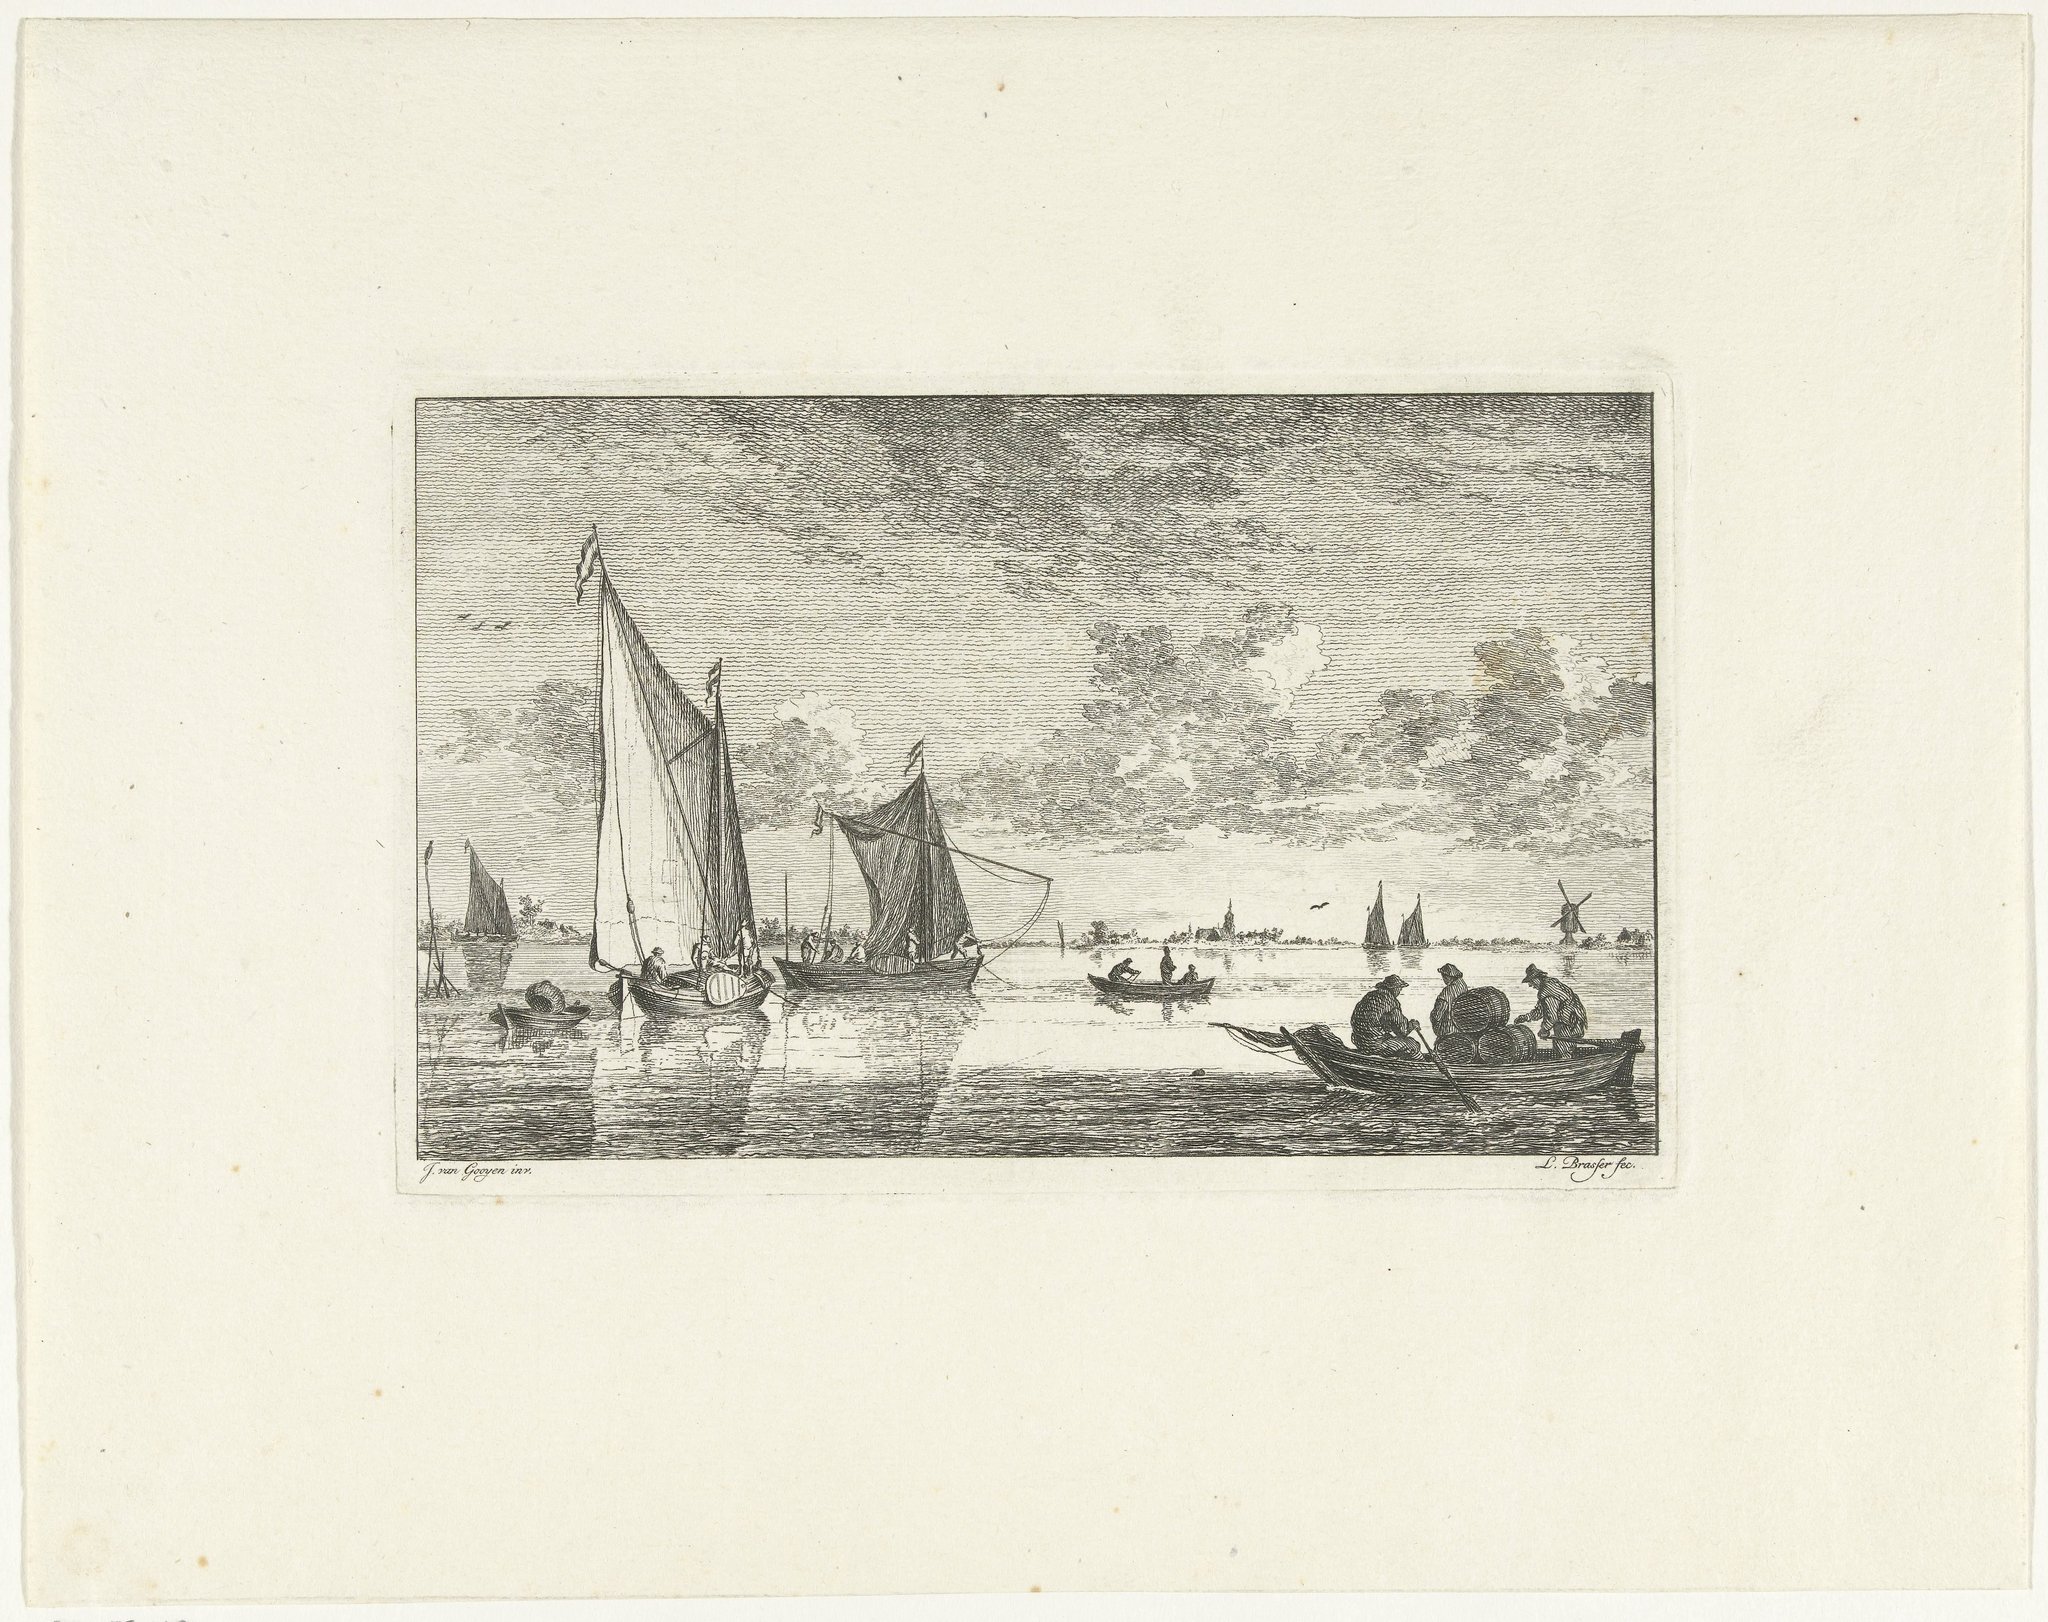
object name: print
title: Boten op het water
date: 1727-1793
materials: paper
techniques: etching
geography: netherlands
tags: ships (in general)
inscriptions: collector's mark: Lugt 240